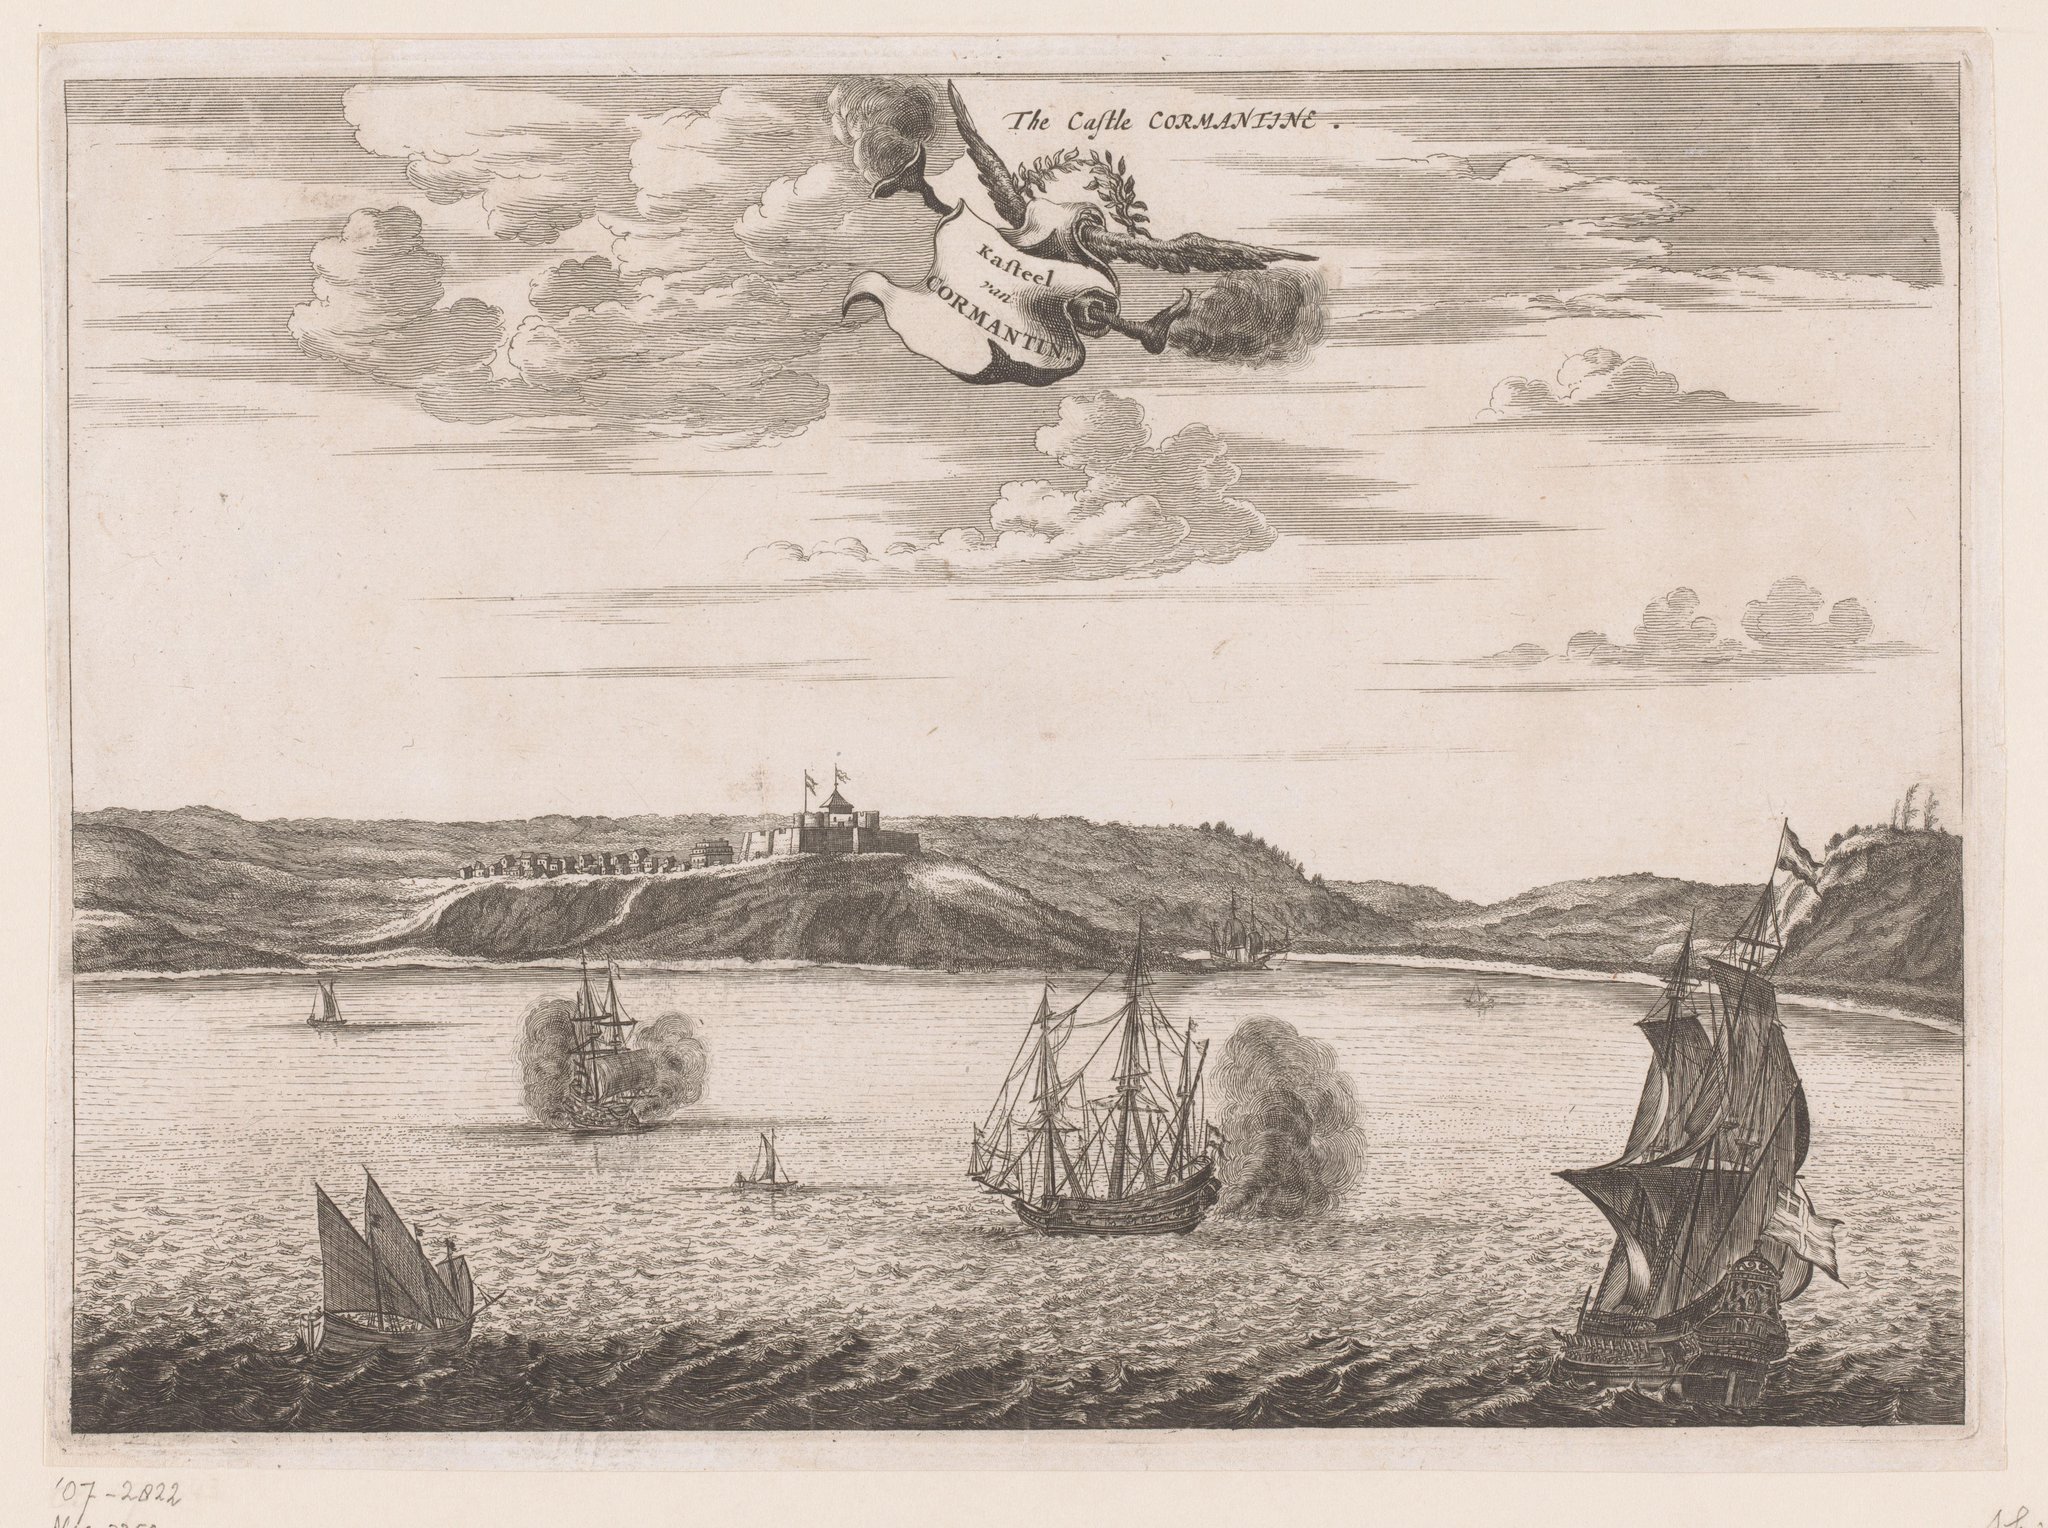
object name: print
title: The Castle Cormantine / Kasteel van Cormantin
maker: Anonymous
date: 1668-1670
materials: paper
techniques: etching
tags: fortress, merchant shipping, shipping trade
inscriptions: collector's mark: Lugt 2228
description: Prent mogelijk uit: Ogilby, John. Africa being an accurate description of the regions of Ægypt, Barbary, Lybia, and Billedulgerid, the land of Negroes, Guinee, Æthiopia and the Abyssines (...). Londen: Thomas Johnson, 1670, of mogelijk uit: Dapper, Olfert. Naukeurige Beschrijvingen der Afrikaensche gewesten. Amsterdam: Jacob van Meurs, 1668.